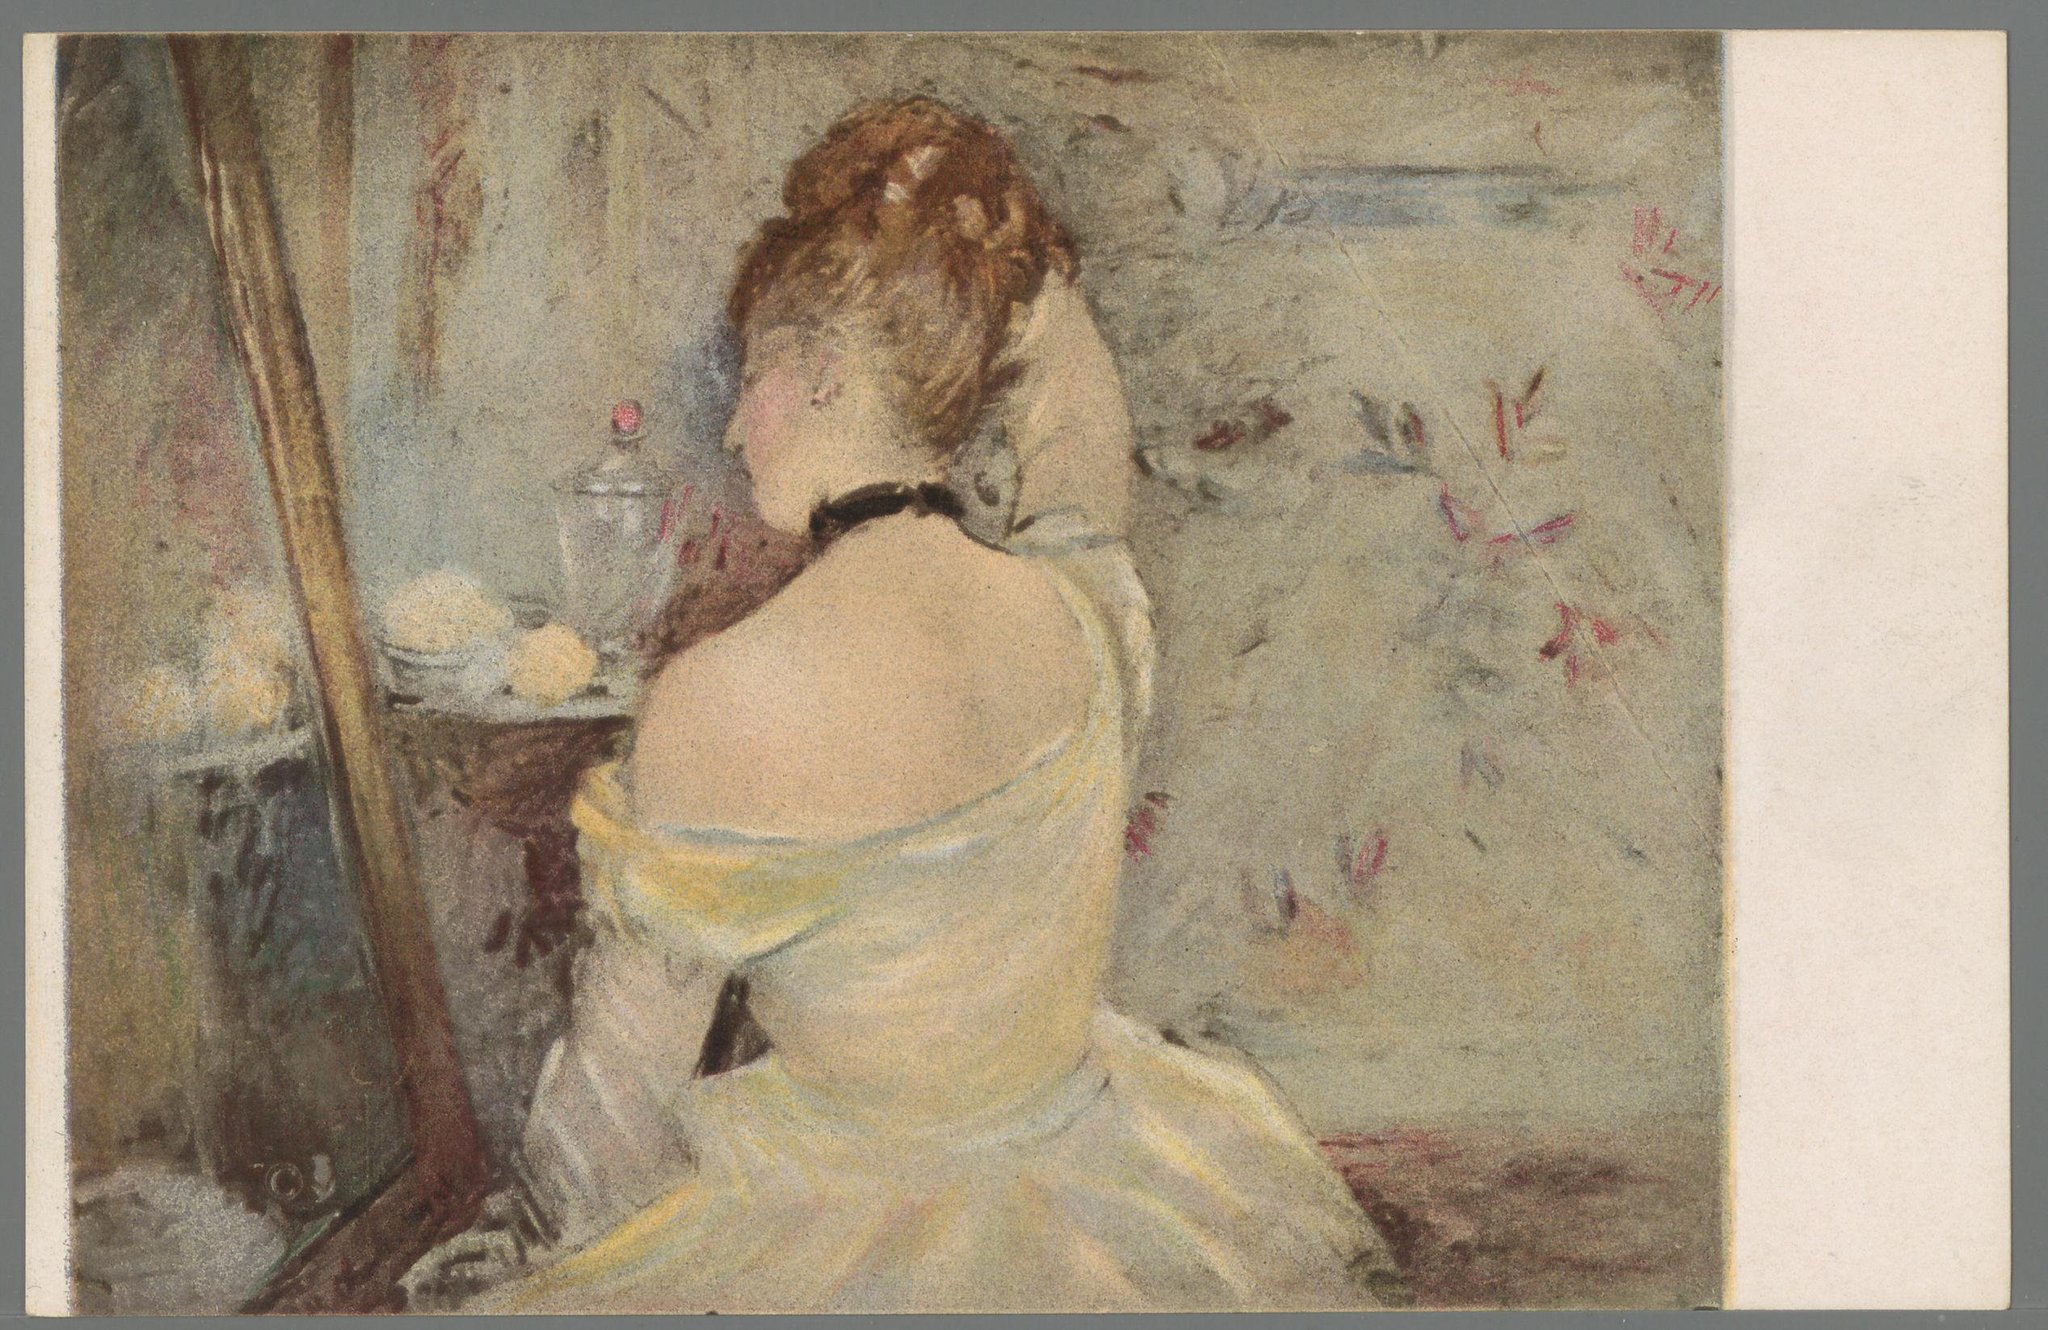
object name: ansichtkaart, prentbriefkaart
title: Femme à sa toilette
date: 1924-1936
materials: cardboard, photographic process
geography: chicago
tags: making toilet, adult woman (+ back view), mirror